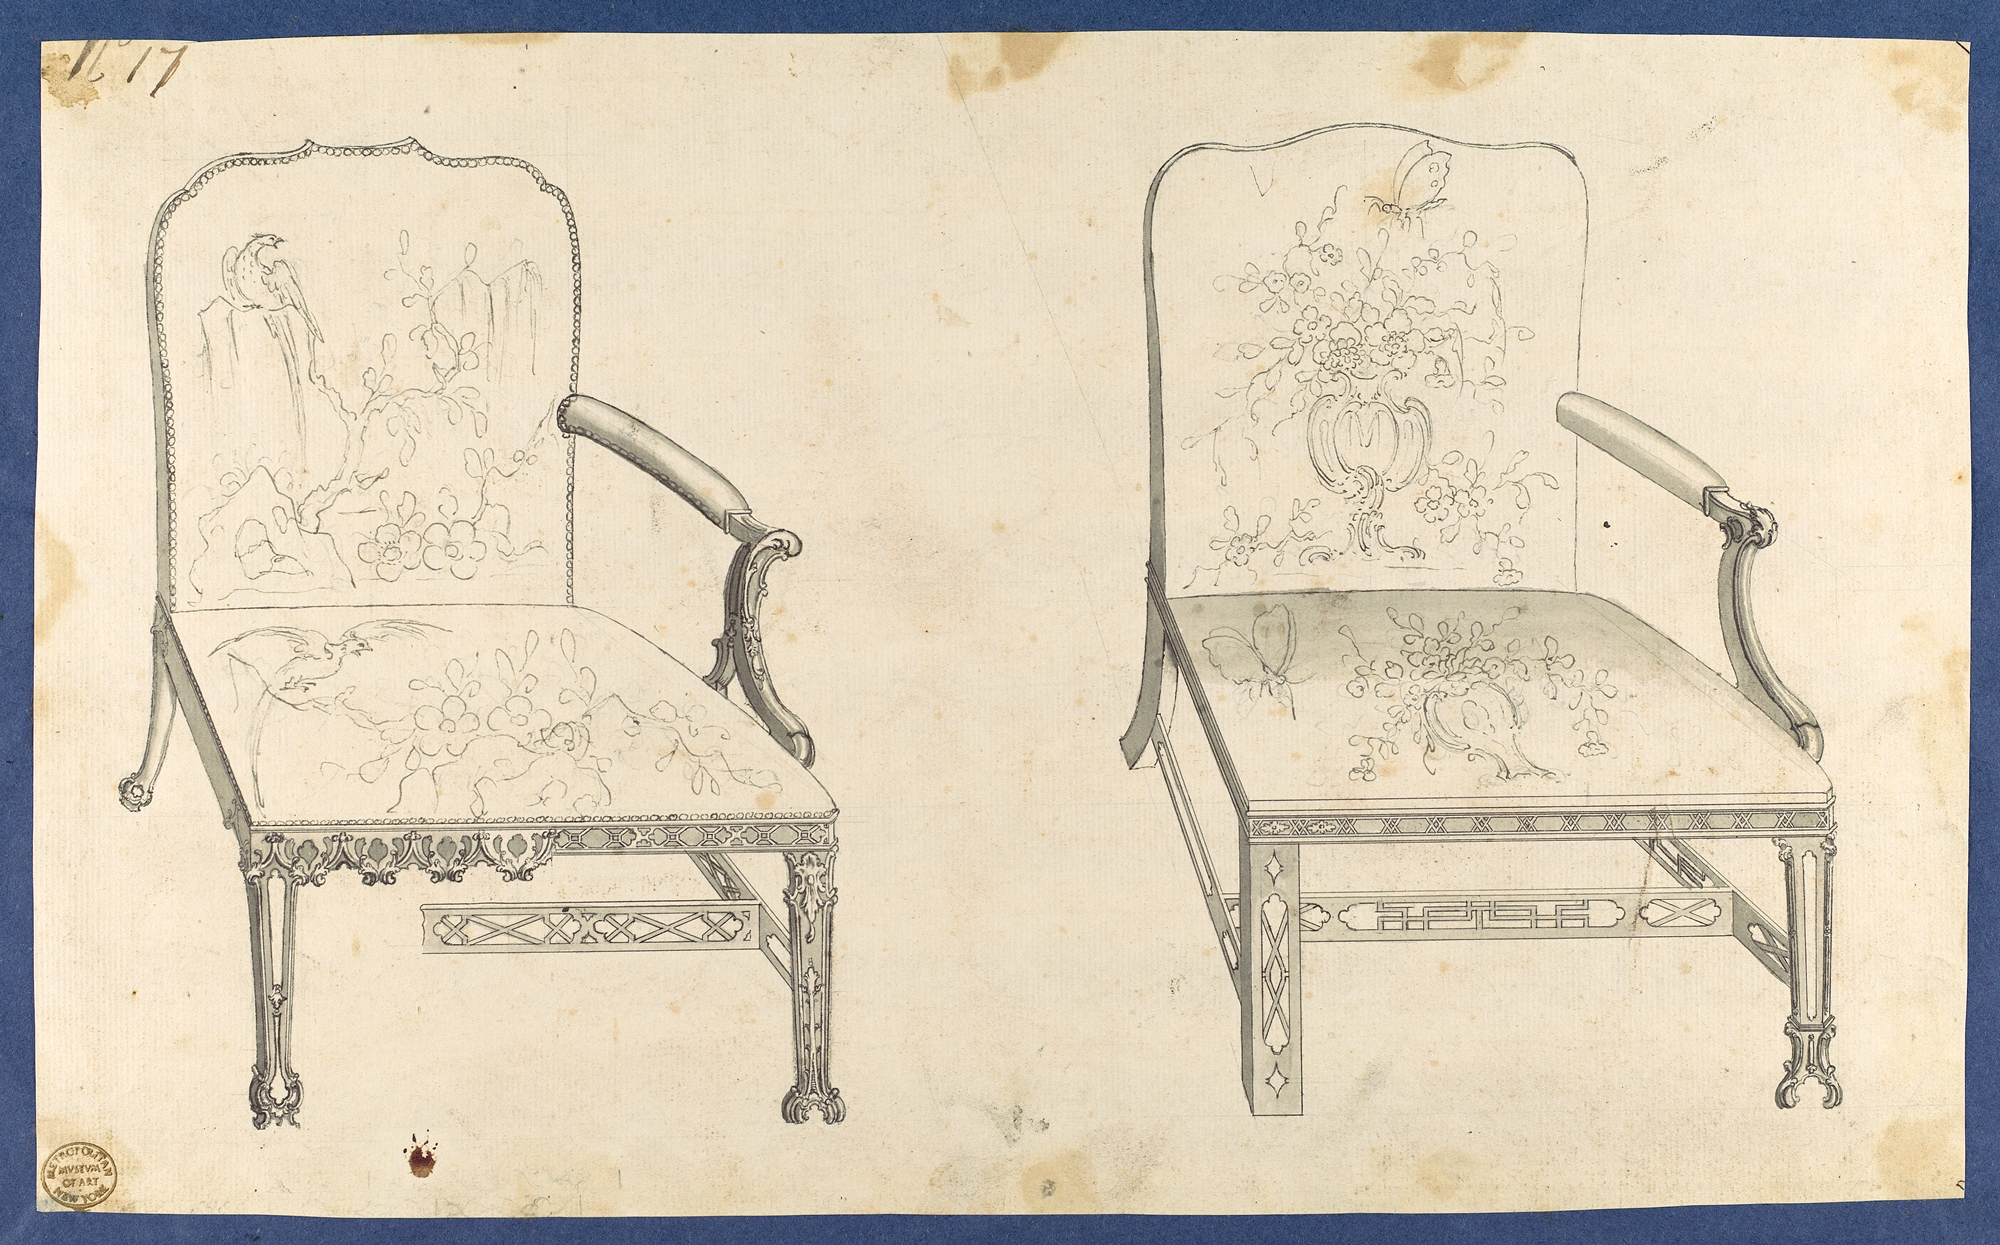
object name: drawing ornament architecture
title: Two French Chairs, in Chippendale Drawings, Vol. I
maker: thomas chippendale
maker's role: artist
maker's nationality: british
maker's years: 1718-1779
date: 1753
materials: ink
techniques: wash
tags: chairs